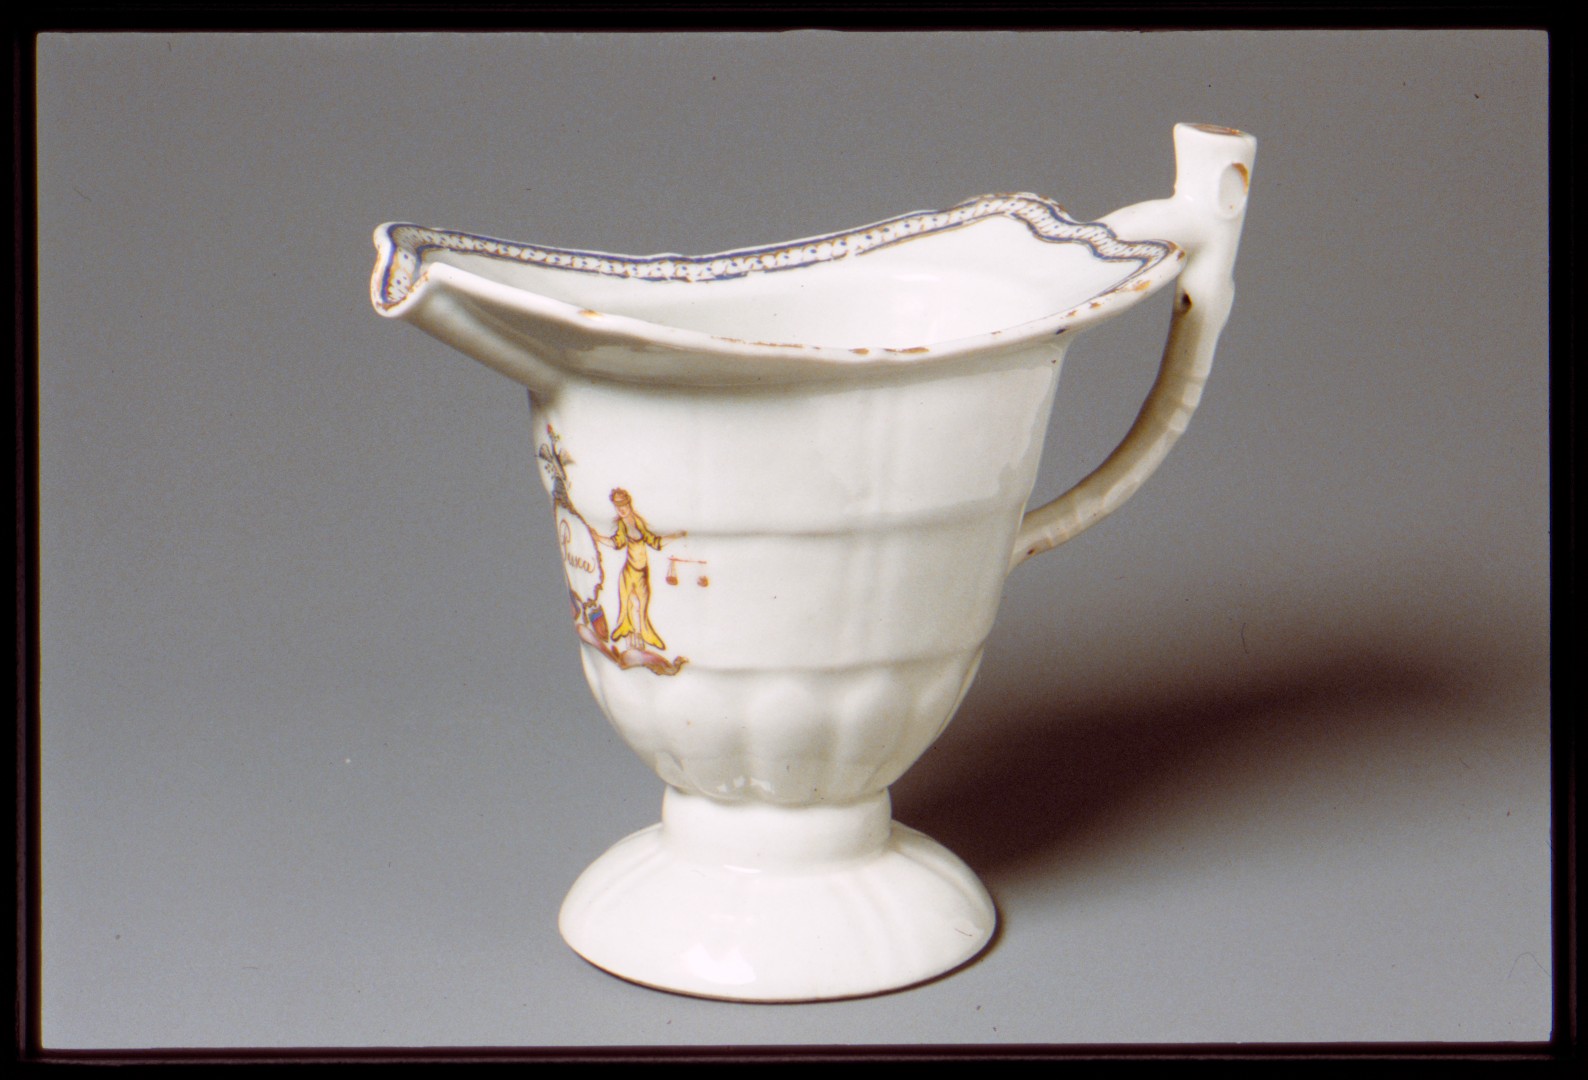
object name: cream pitcher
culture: chinese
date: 1770-1800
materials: porcelain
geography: china